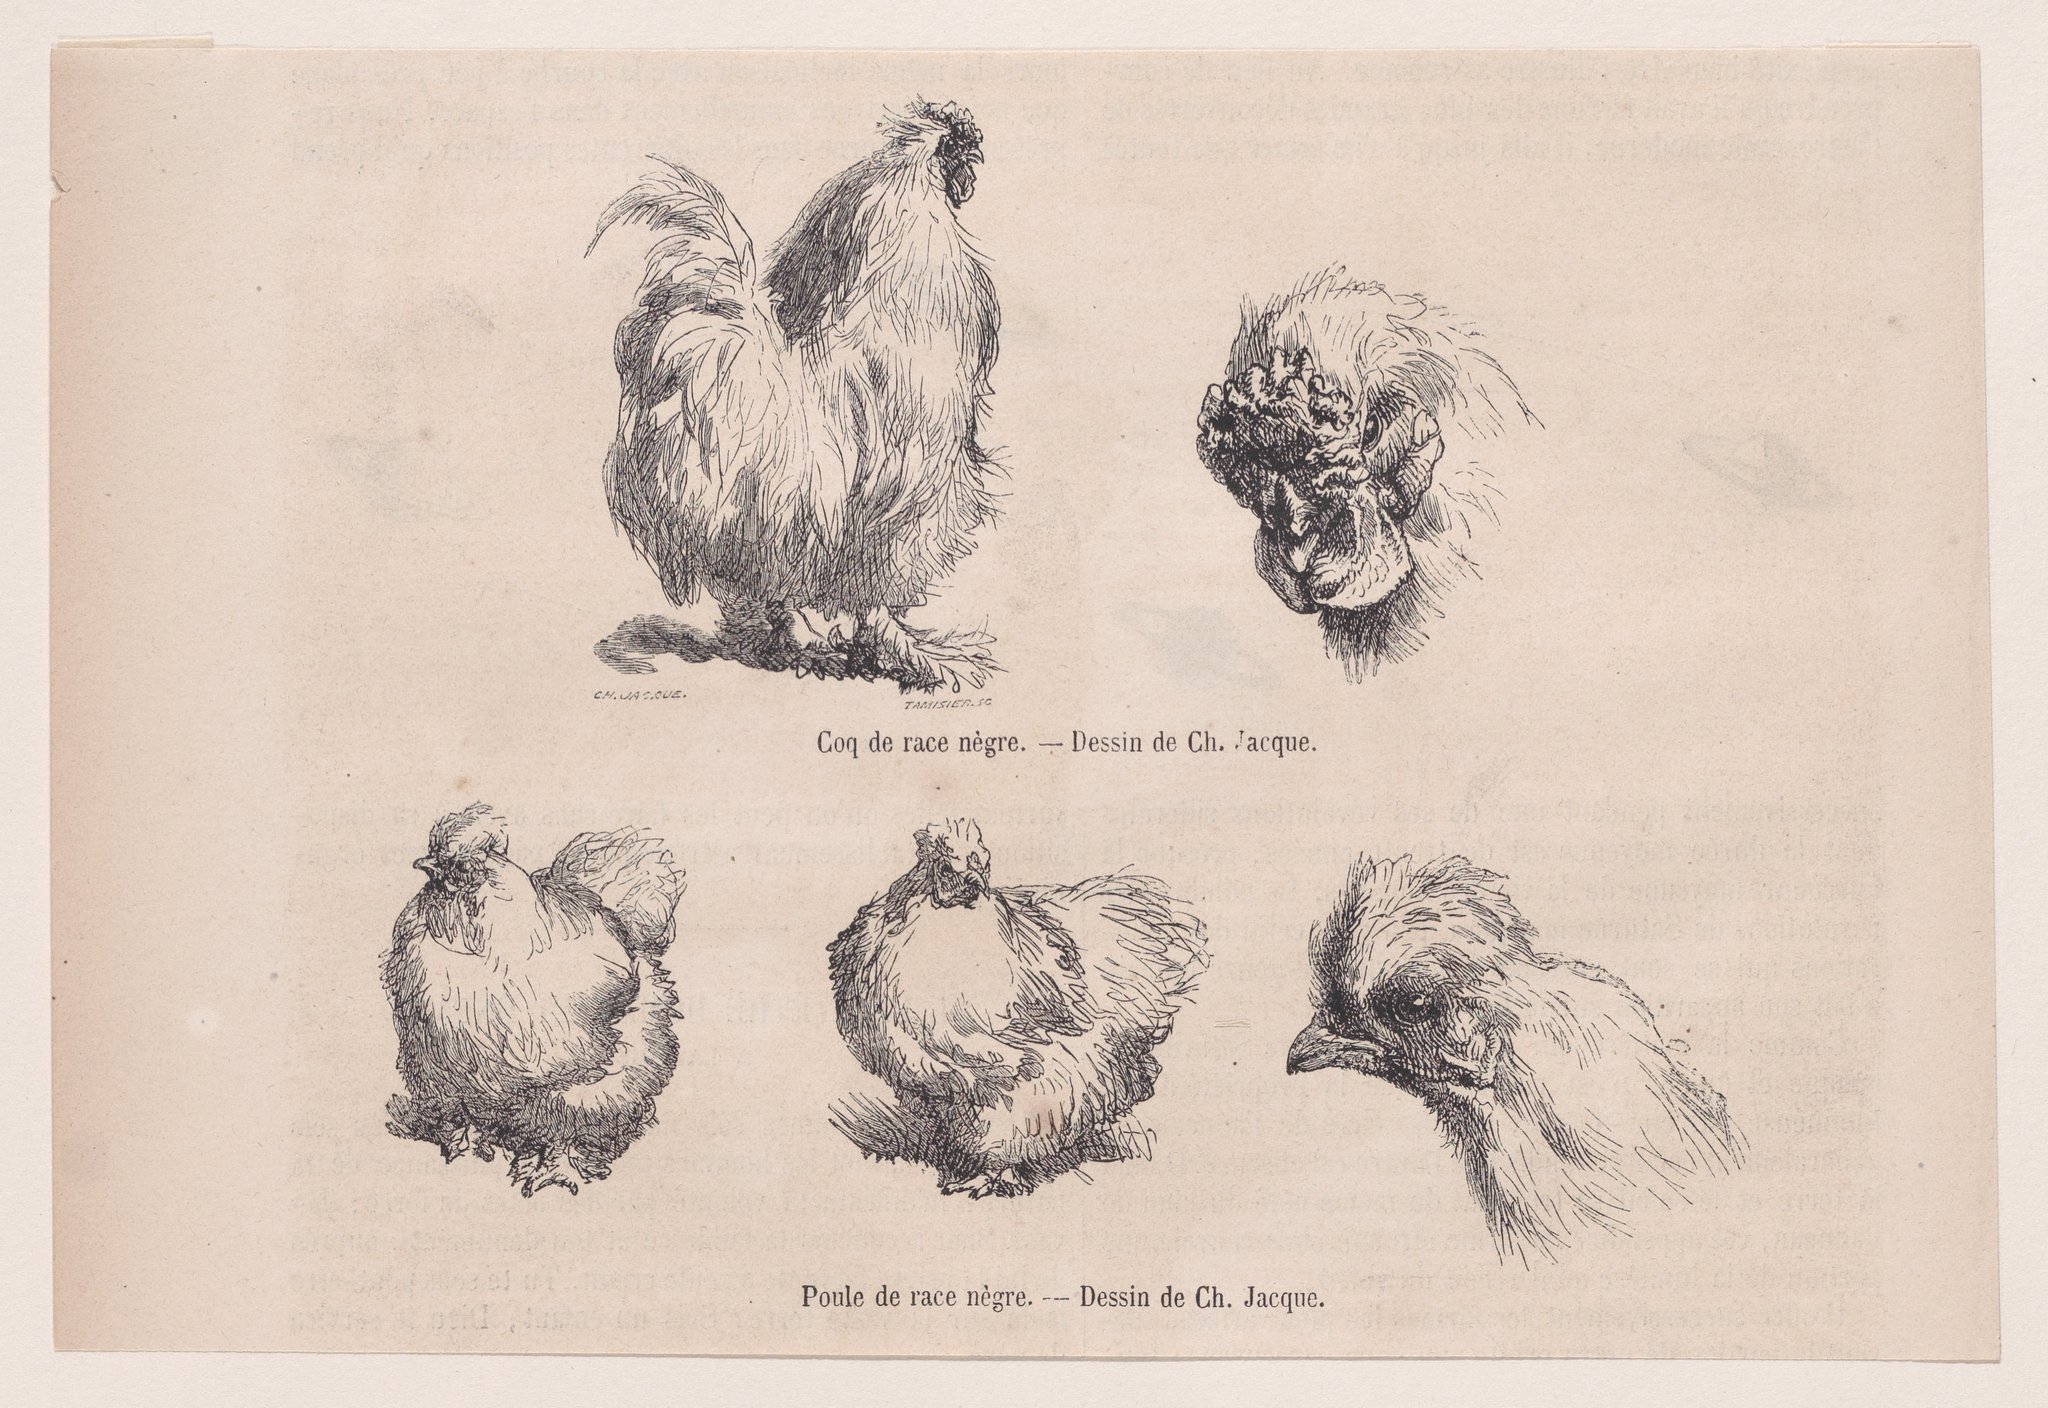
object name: print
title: Silkie Cockerel and Silkie Hen, from "Le Magasin Pittoresque"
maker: charles émile jacque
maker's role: artist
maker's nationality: french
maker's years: 1813-1894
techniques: engraving